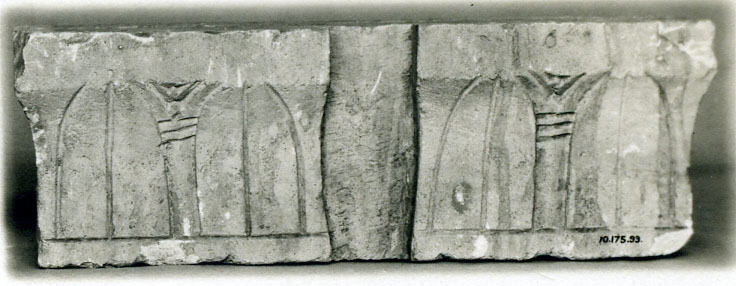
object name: capital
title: Capital of a Double Pilaster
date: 501-700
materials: limestone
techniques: carving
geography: egypt